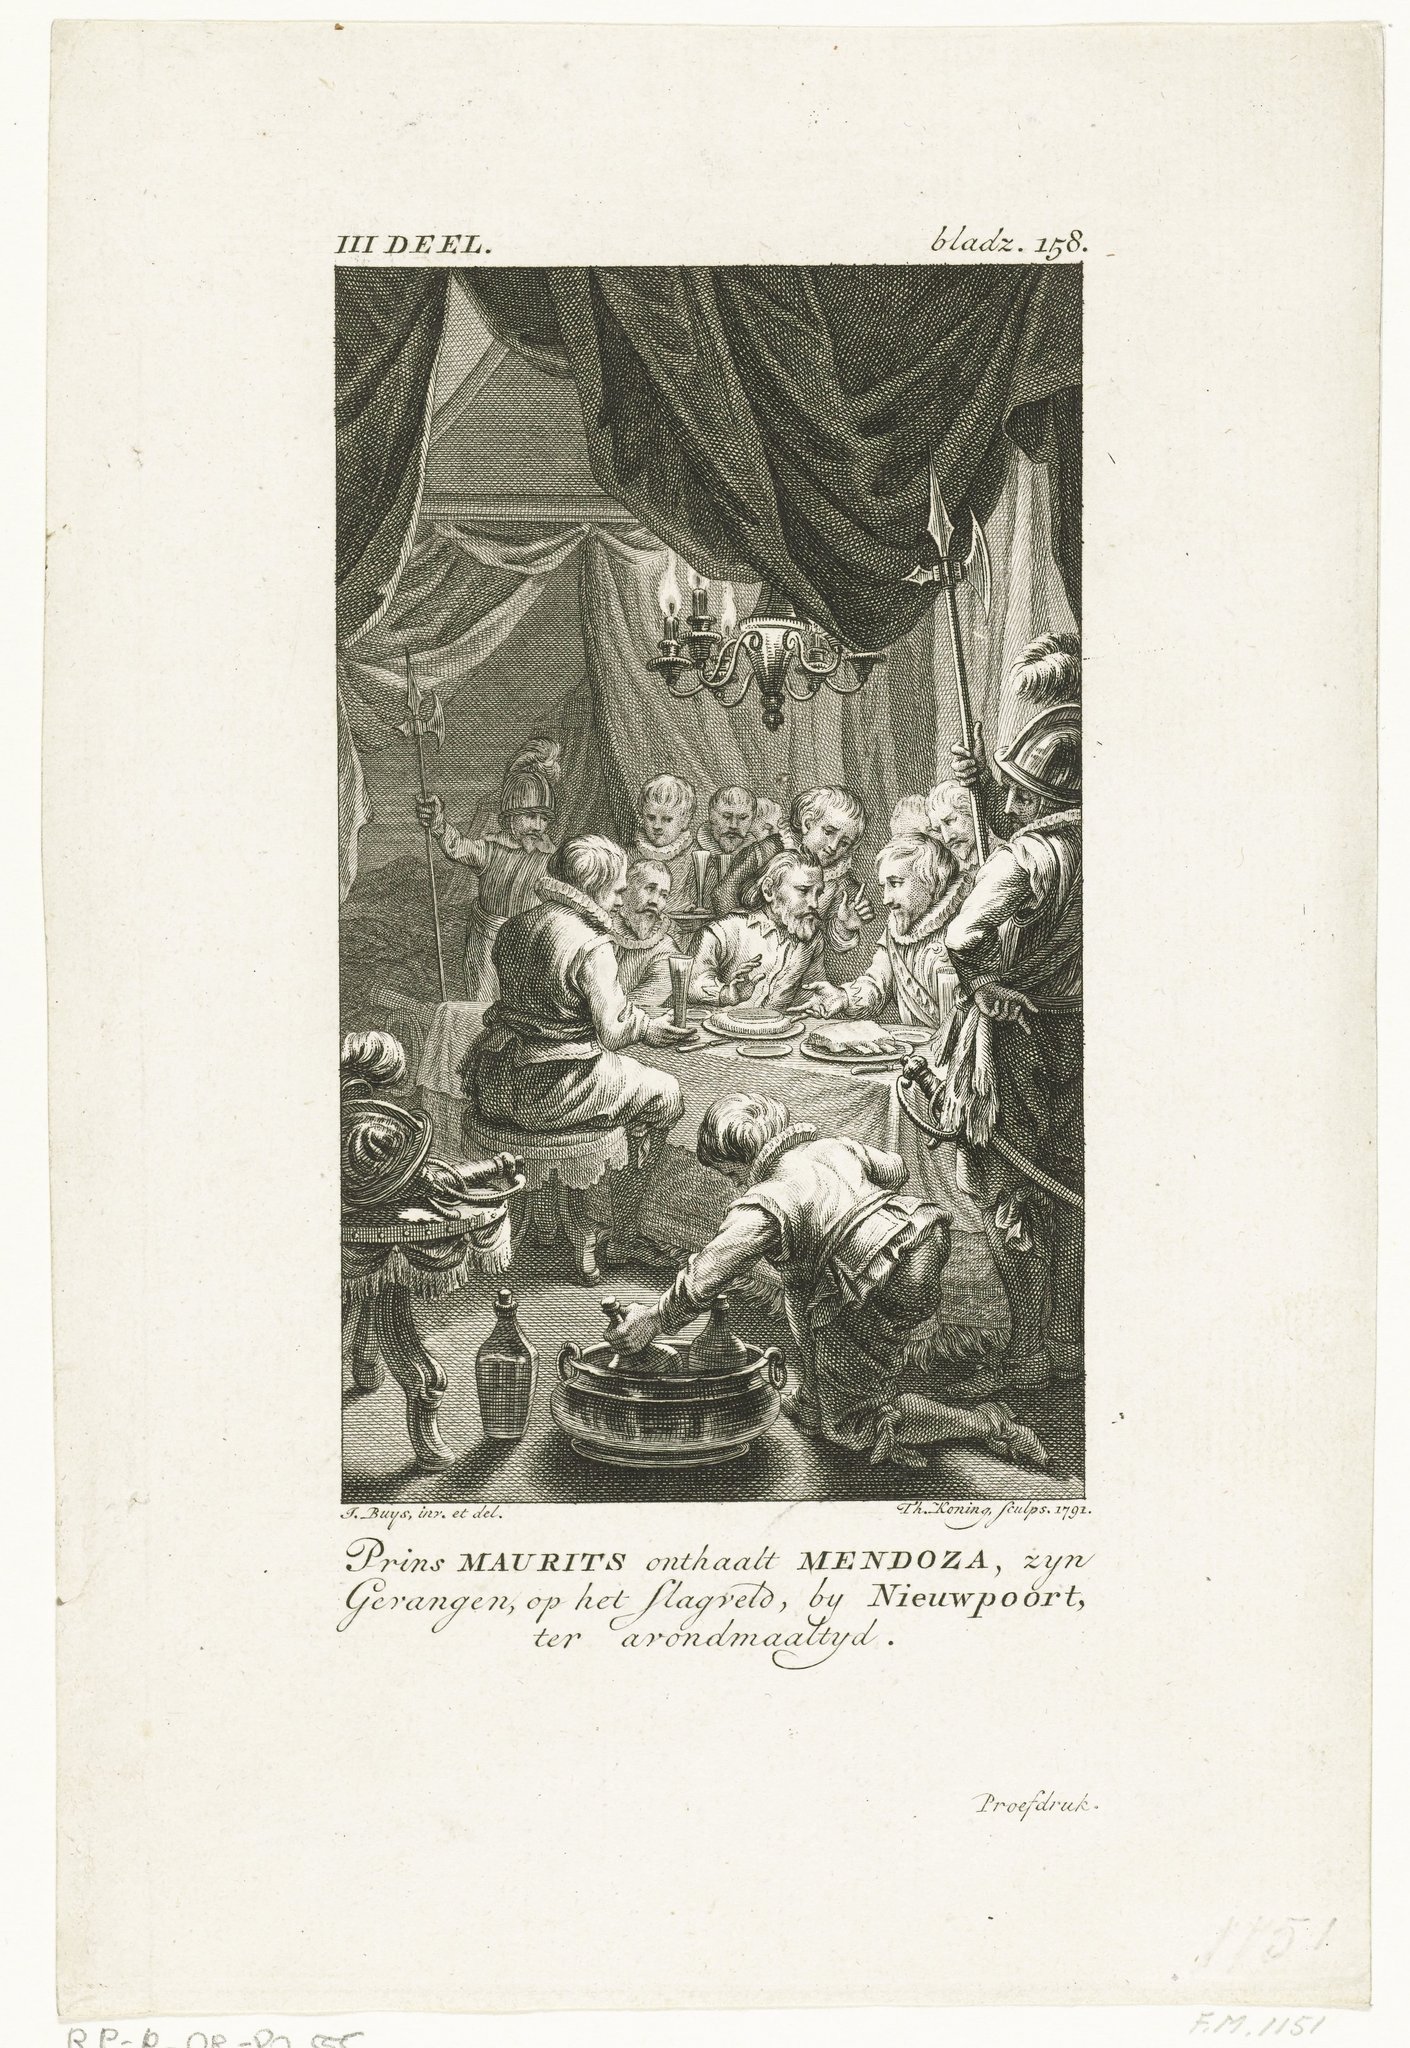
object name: history print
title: Prins Maurits onthaalt Mendoza, zijn Gevangen, op het Slagveld, by Nieuwpoort, ter avondmaaltyd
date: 1791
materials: paper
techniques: etching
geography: netherlands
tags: maurice (prince of orange), evening meal, dinner, supper, battle of nieuwpoort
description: Prins Maurits deelt zijn avondmaal in zijn legertent met de gevangengenomen Spaanse veldheer Francisco de Mendoza, de avond na de slag bij Nieuwpoort, 2 juli 1600.